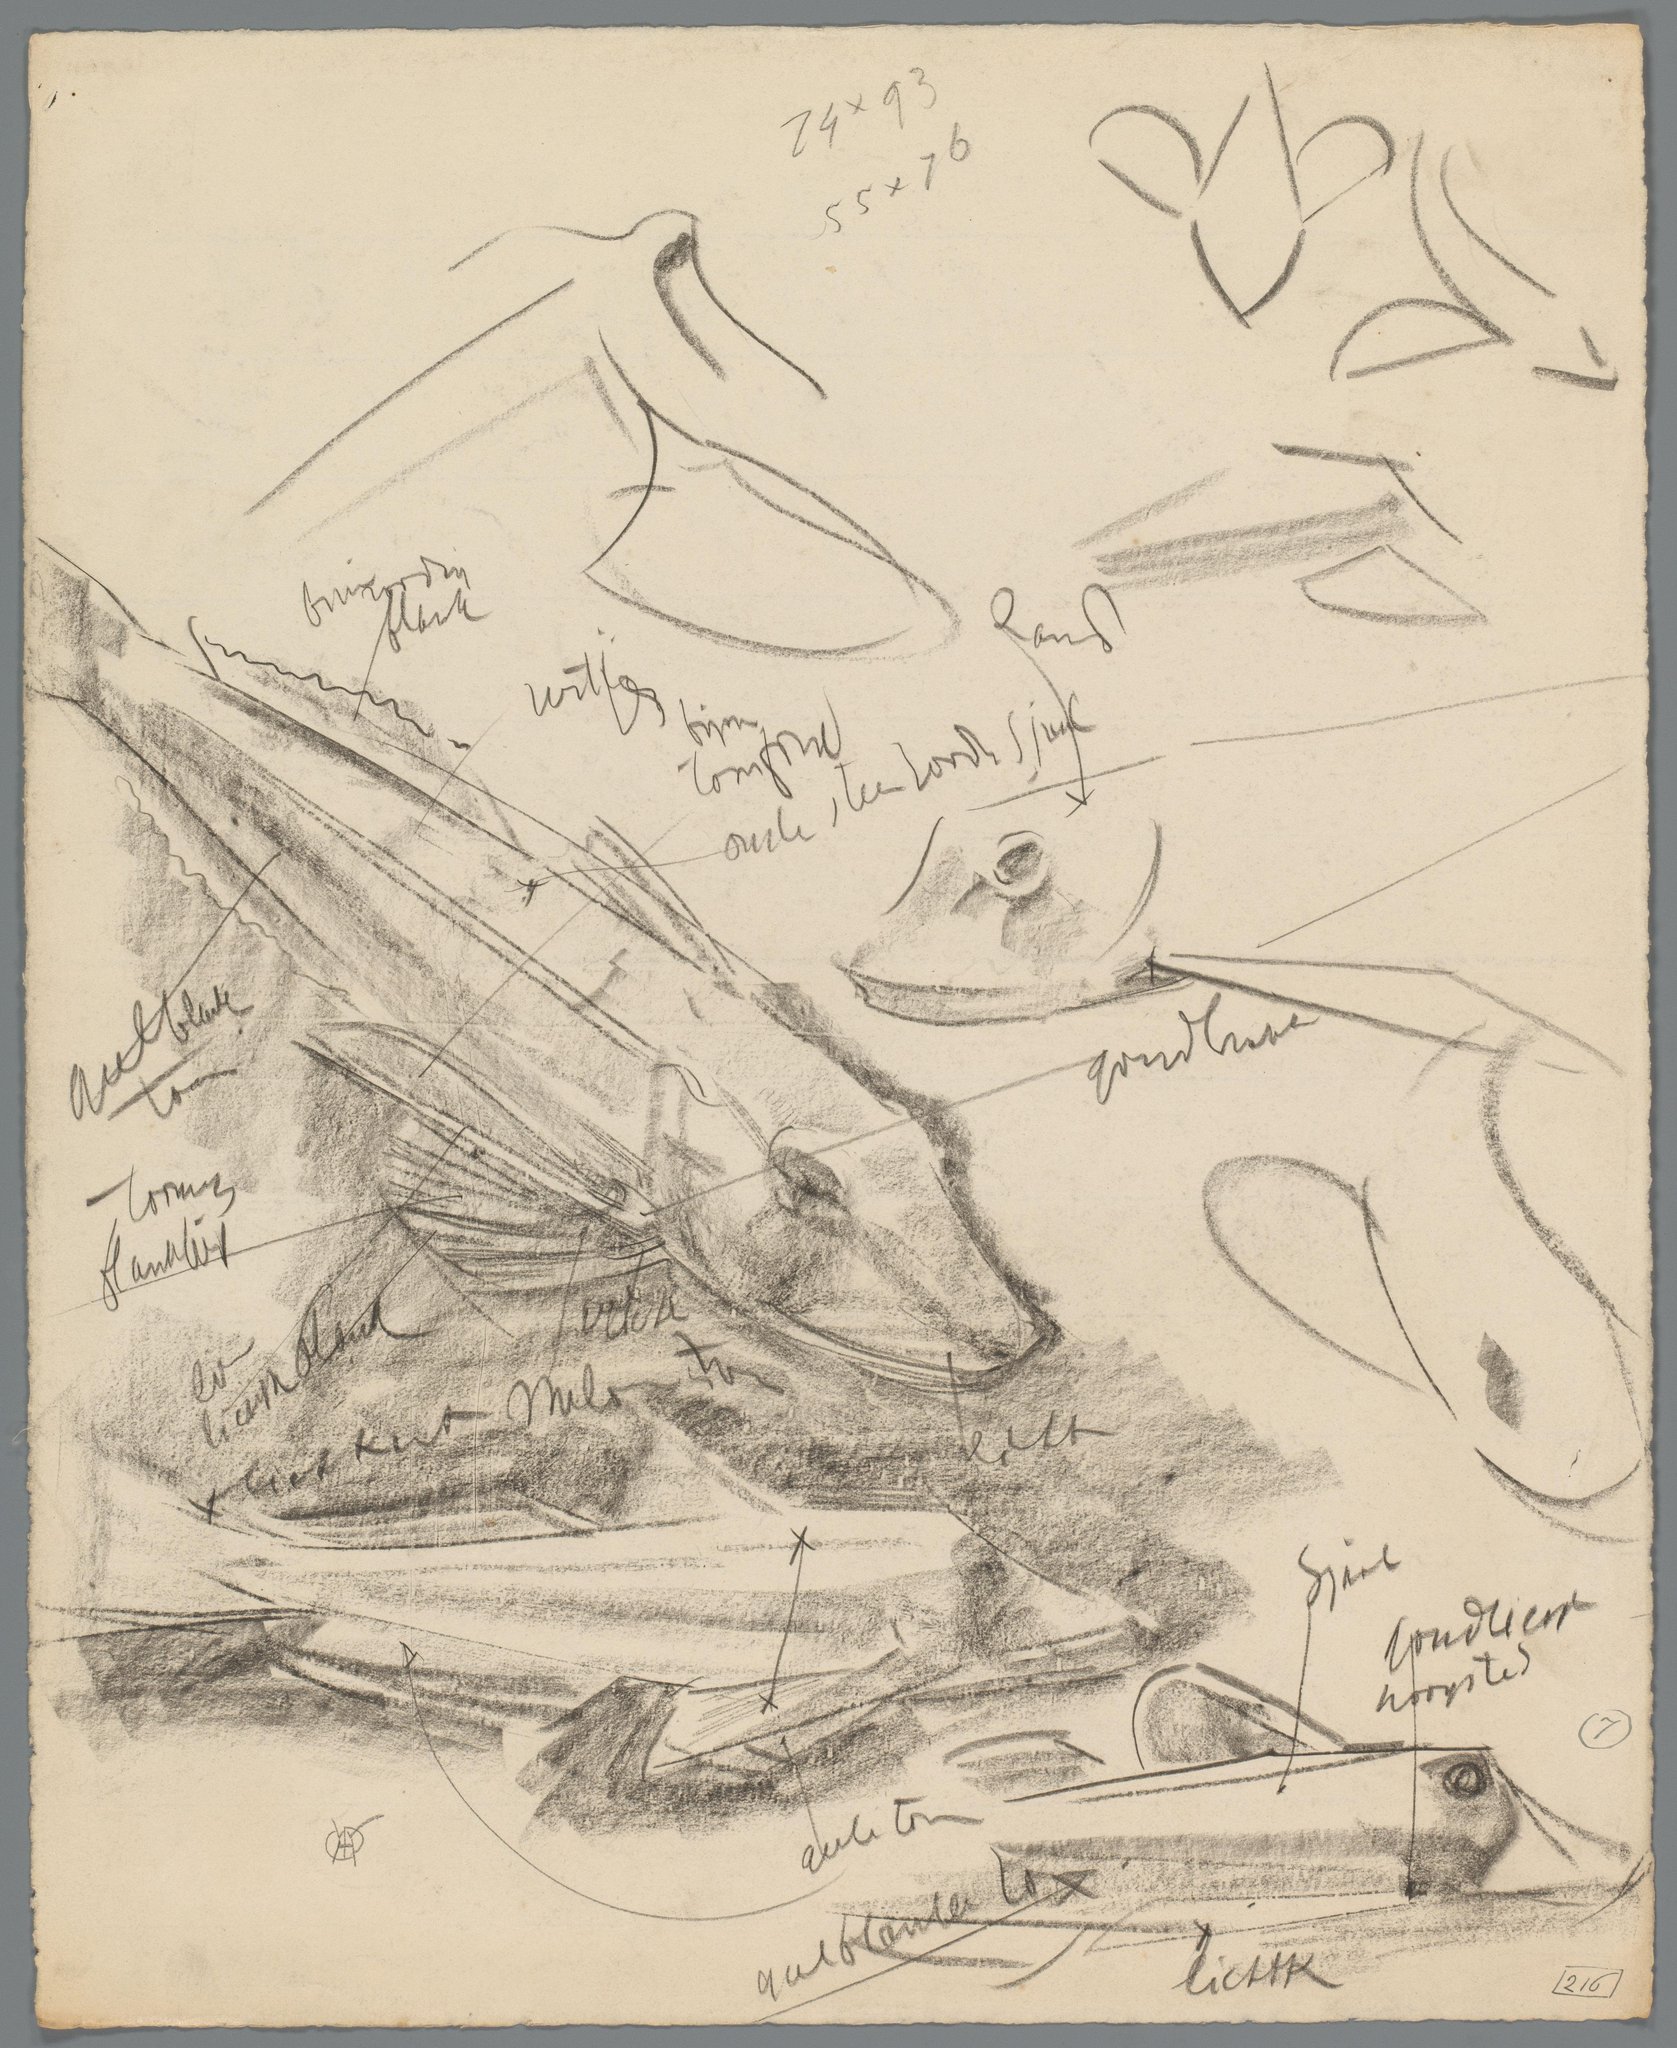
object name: drawing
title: Studies van rode ponen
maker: gerrit willem dijsselhof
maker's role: designer, draughtsman, print maker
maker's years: 1866-1924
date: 1876-1924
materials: chalk, paper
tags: fishes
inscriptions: number: ‘216’, number: ‘7’